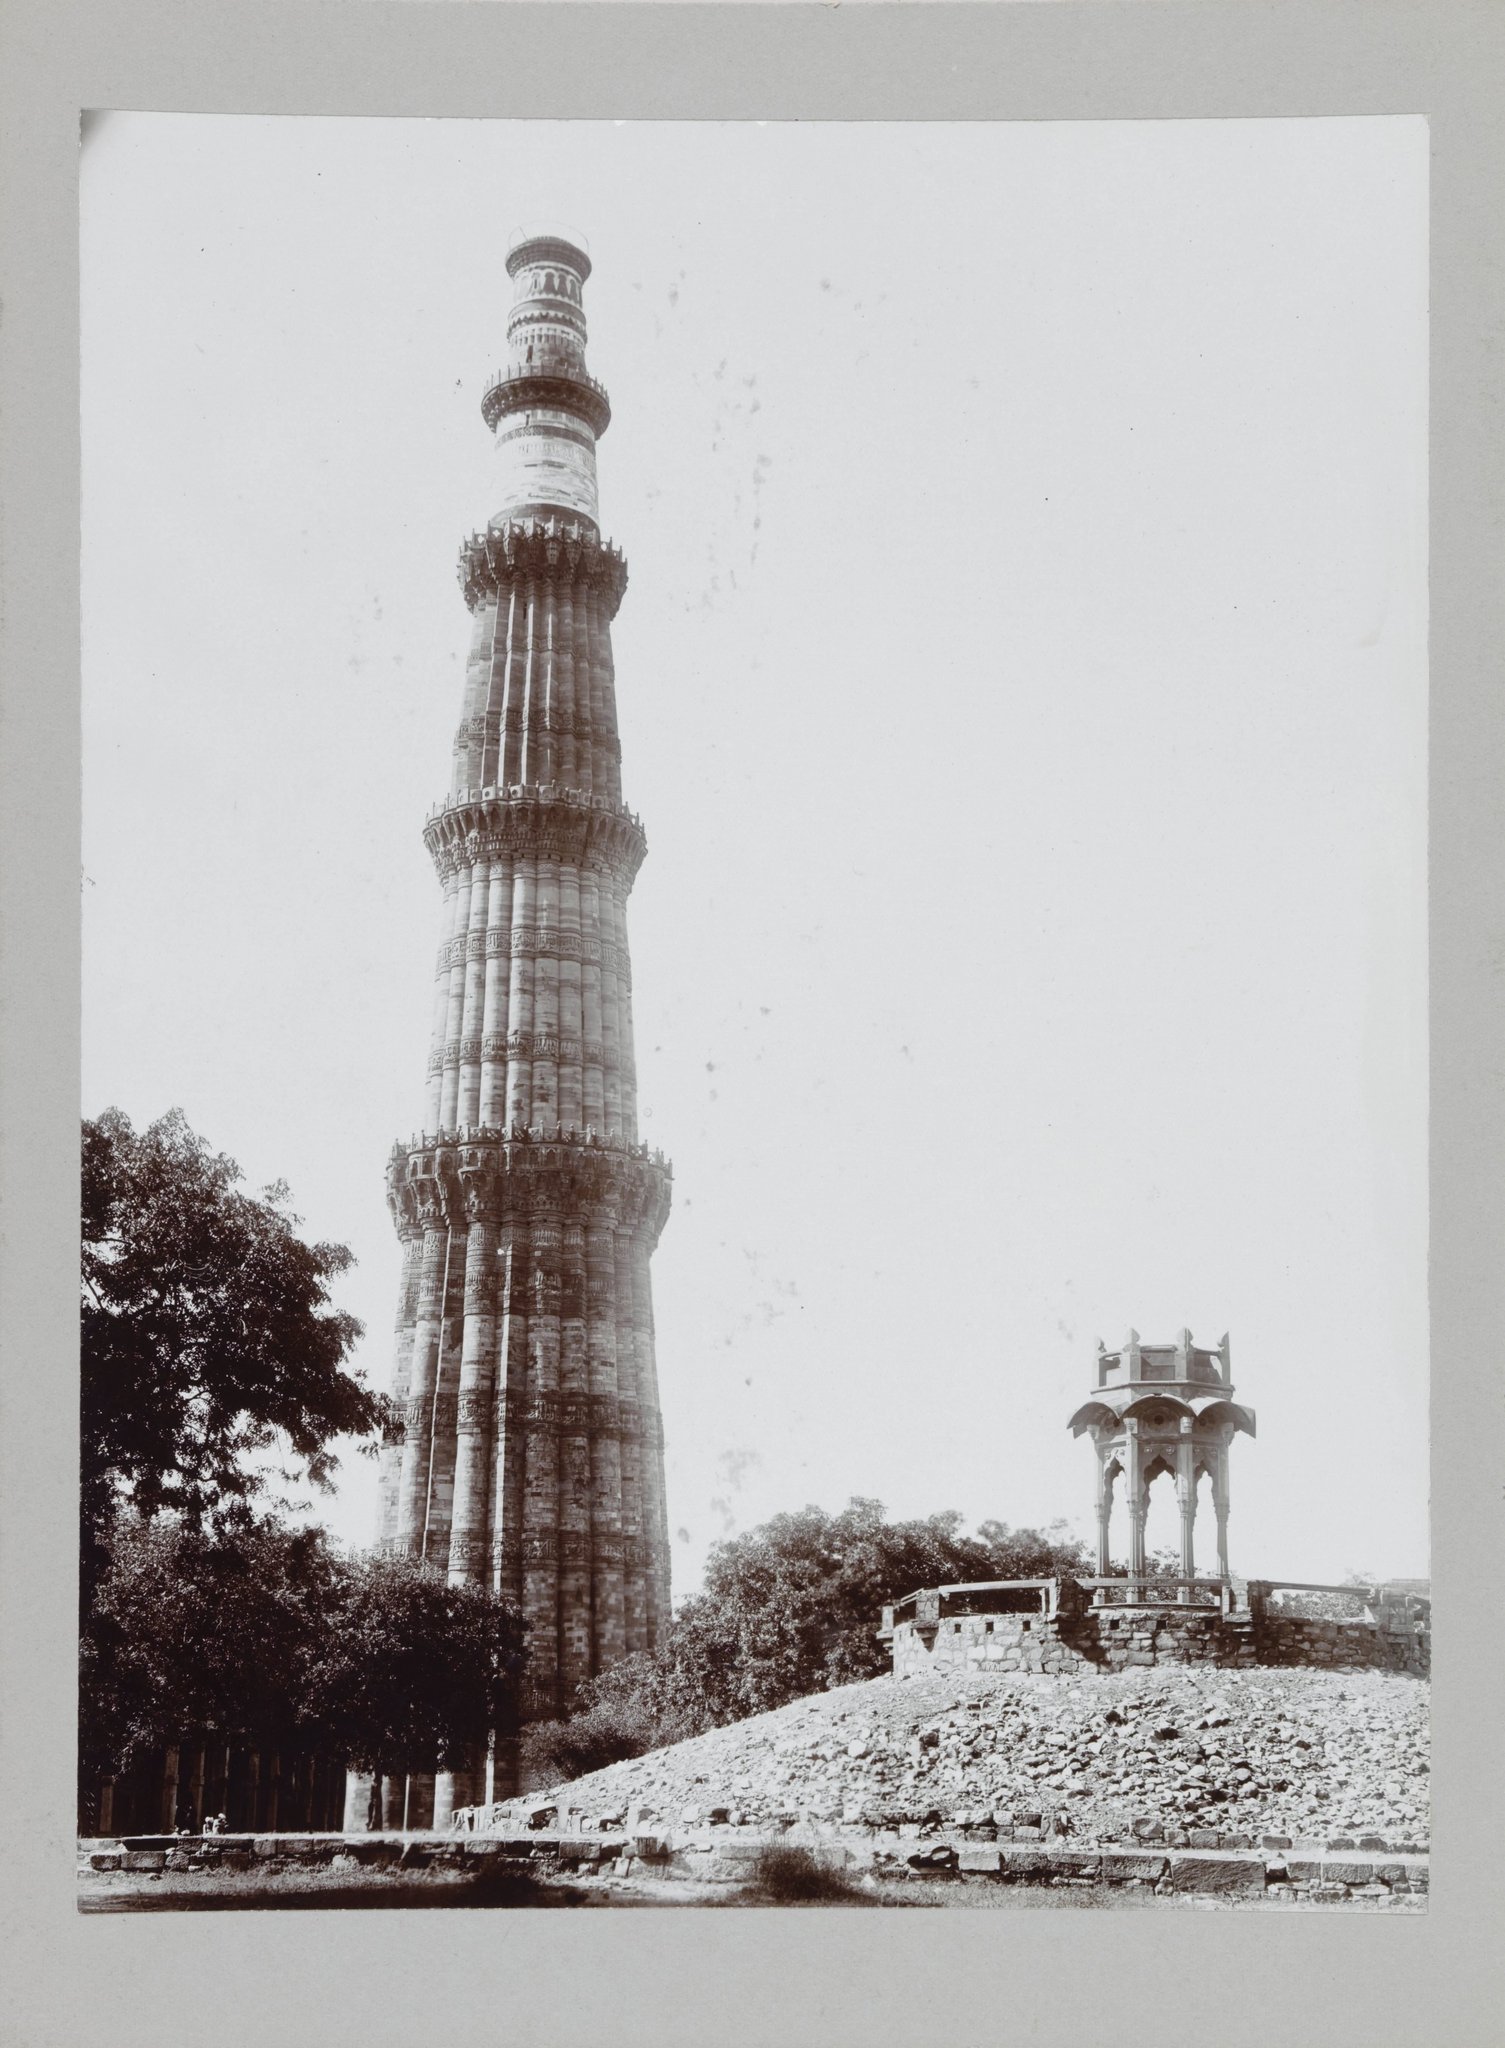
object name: photograph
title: Qutb Minar, Delhi, India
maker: Anonymous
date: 1895-1915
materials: cardboard, paper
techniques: gelatin silver print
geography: delhi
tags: delhi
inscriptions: annotation: ‘41. Kutab Minar bij Delhi.’